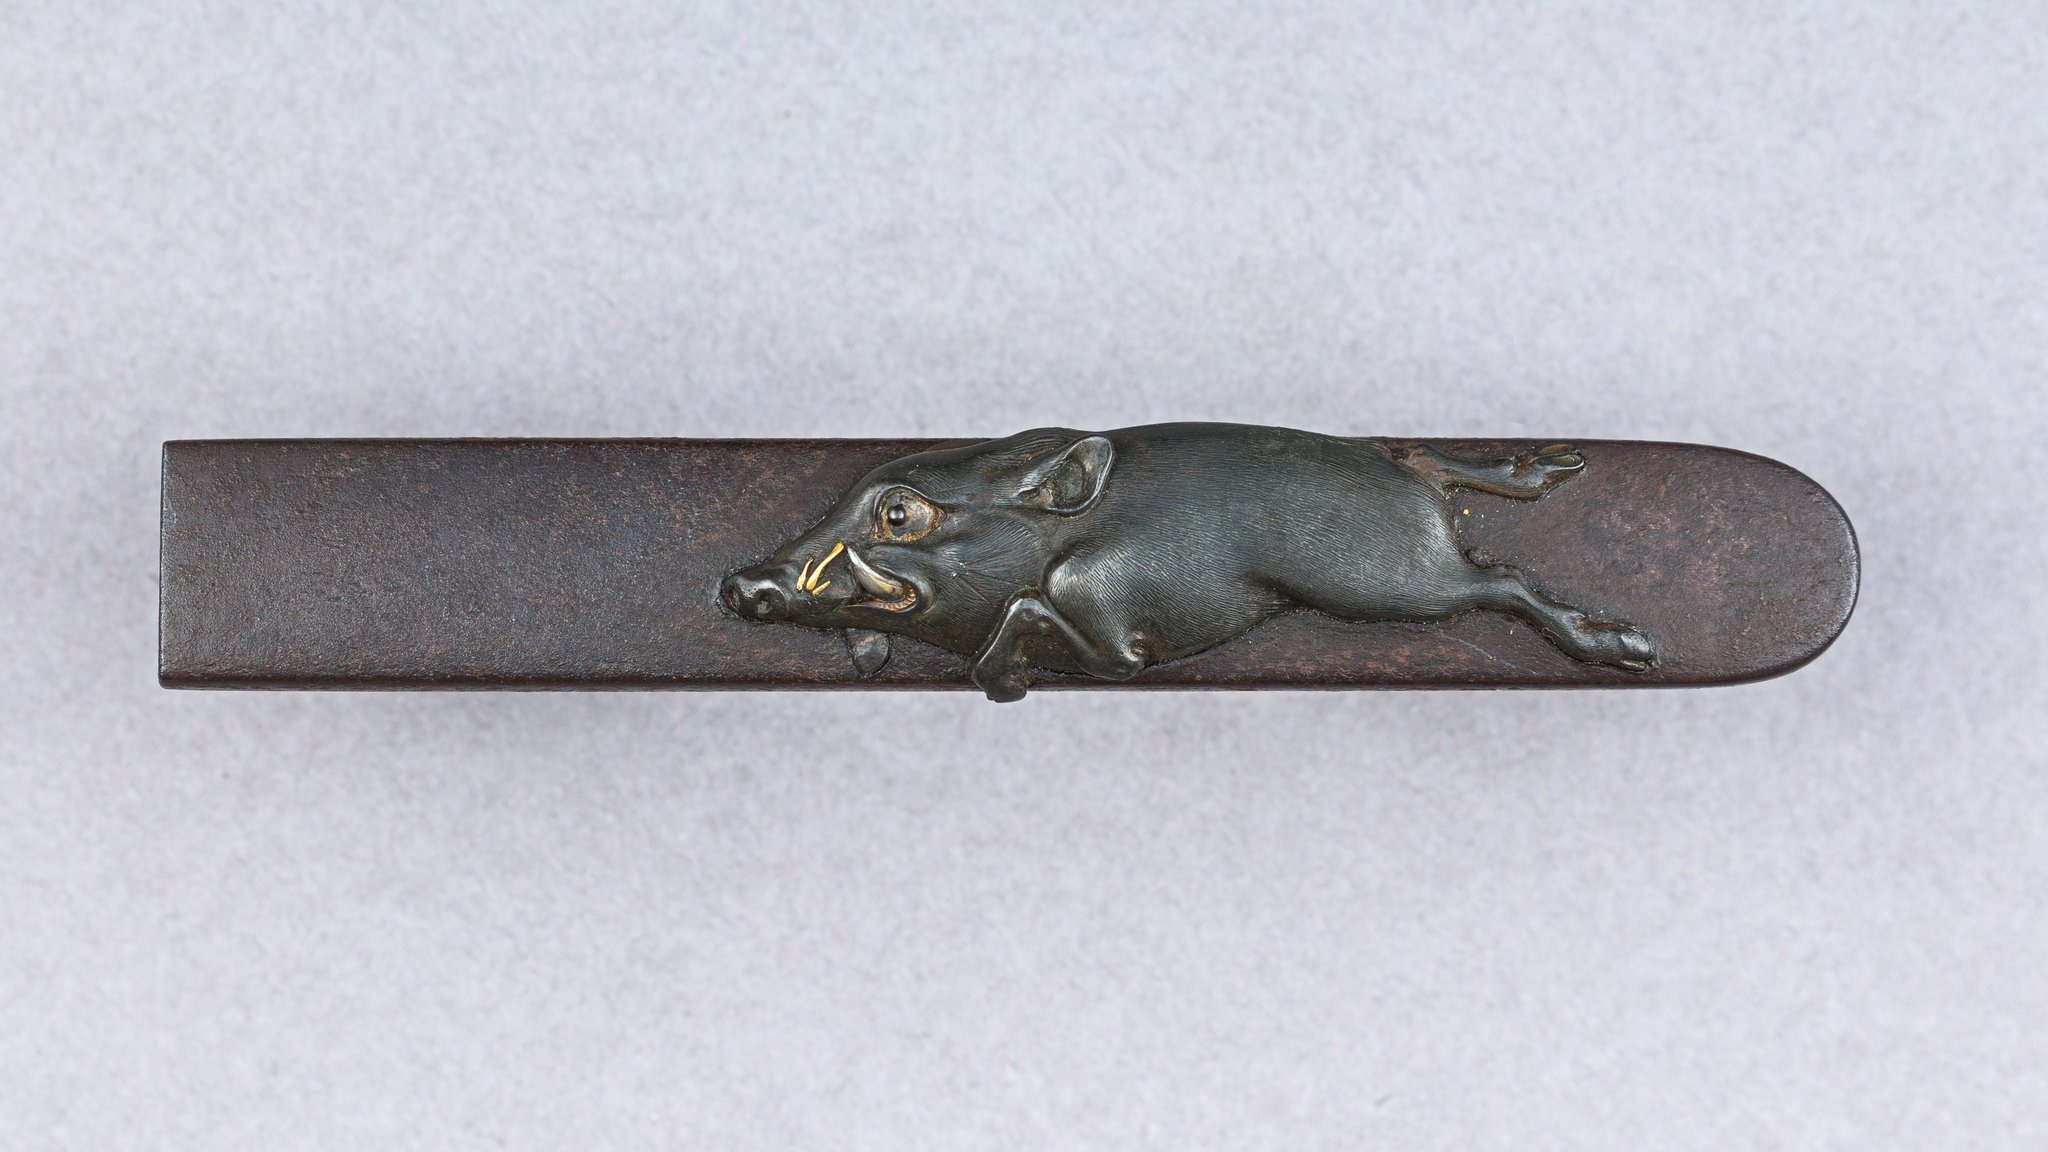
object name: knife handle kozuka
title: Knife Handle (Kozuka)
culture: japanese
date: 1801-1900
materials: gold alloy, silver alloy, gold, iron, silver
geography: japan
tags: pigs